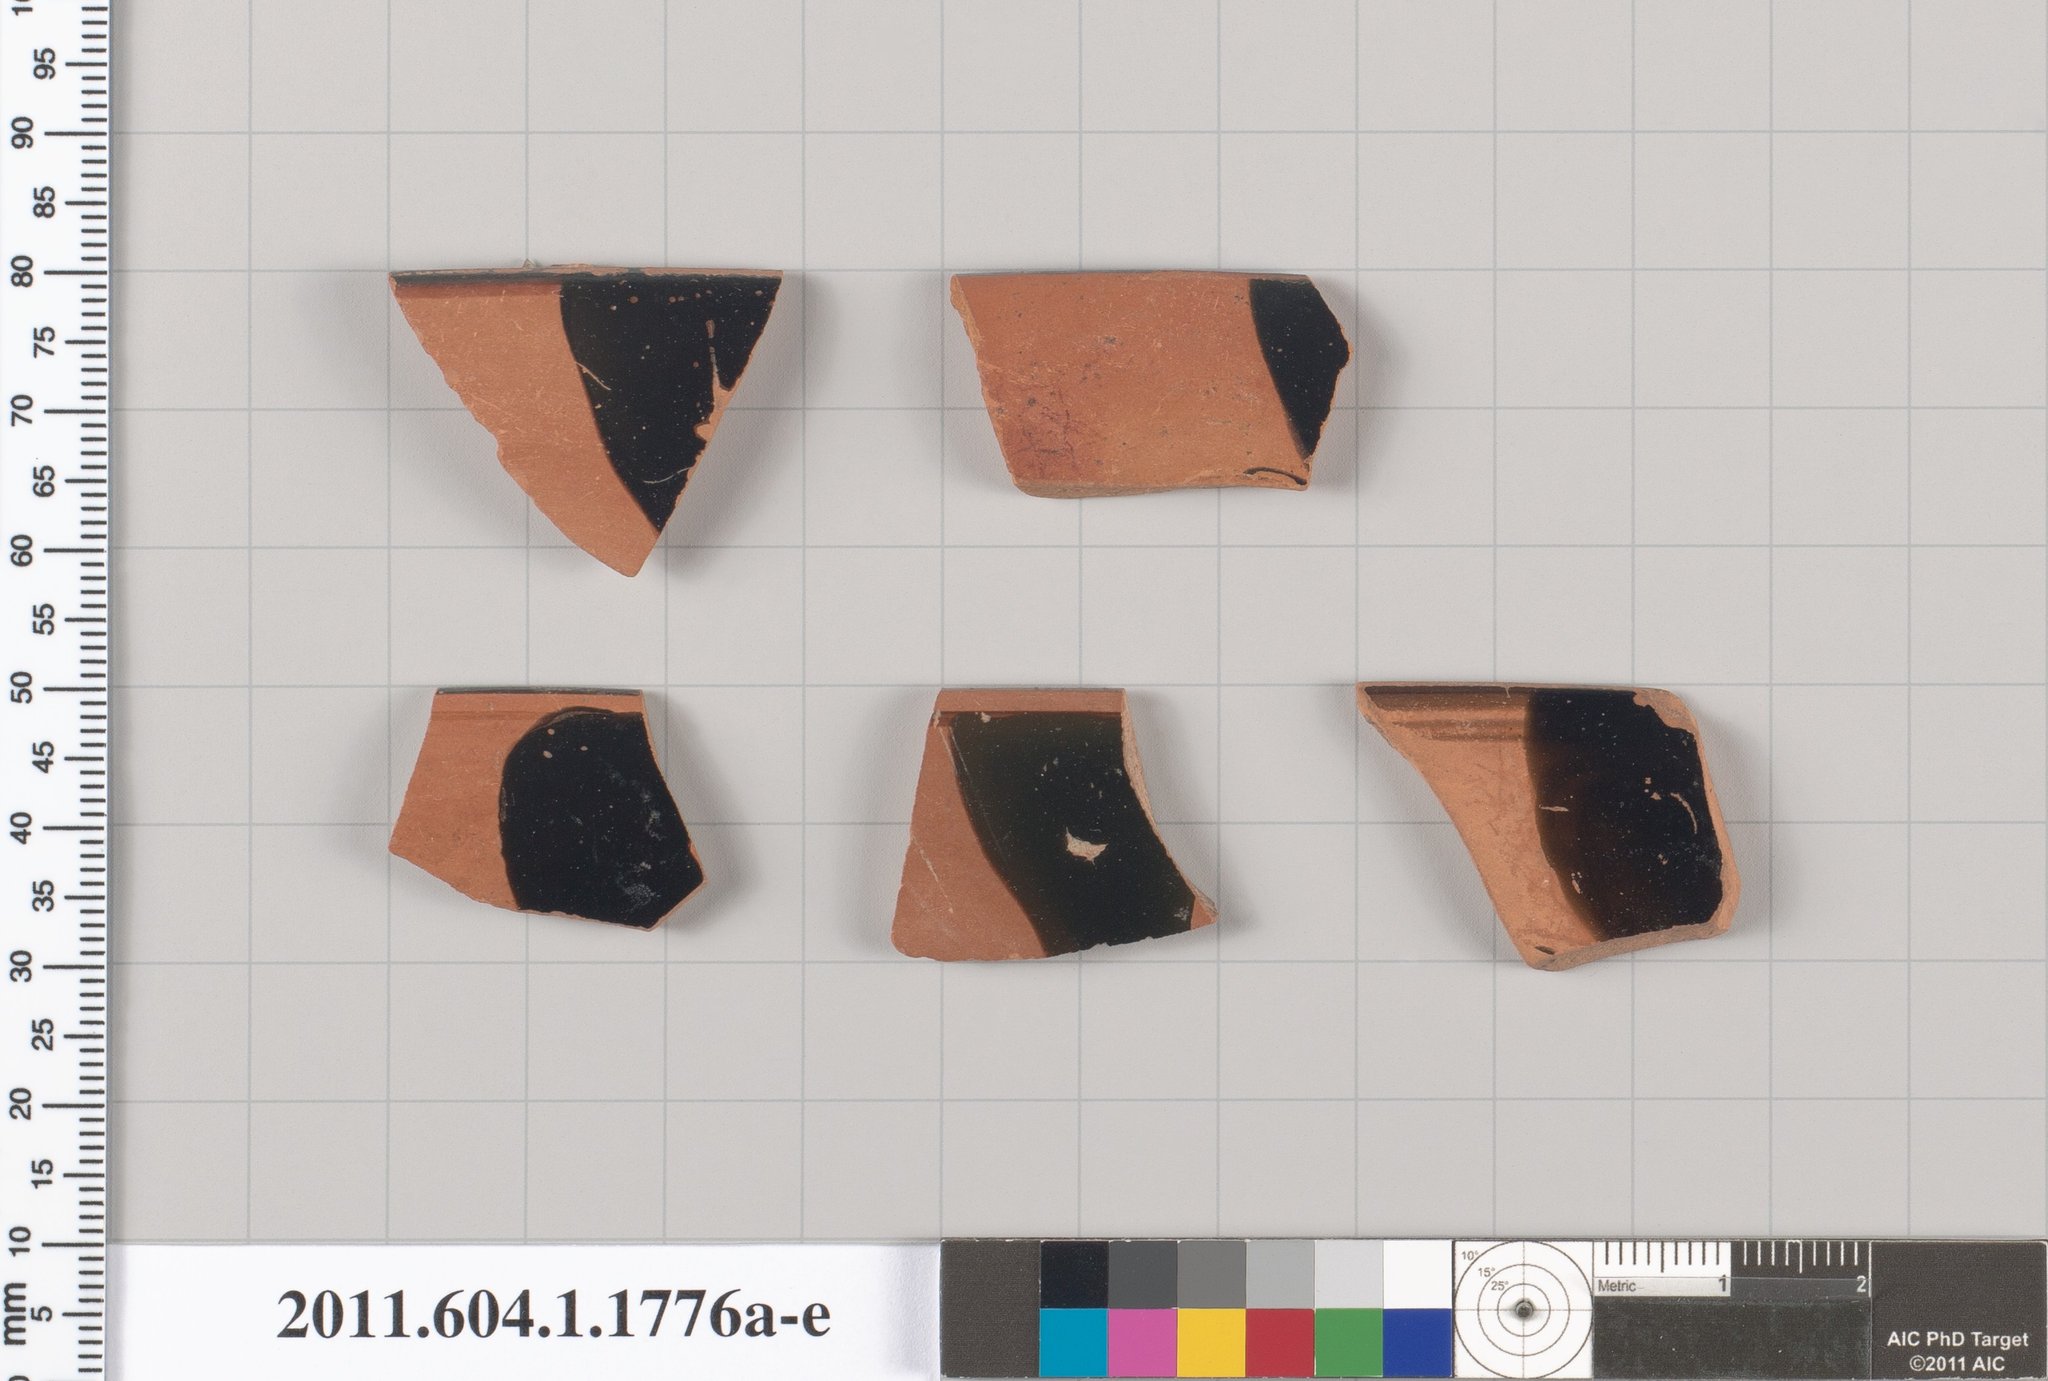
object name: kylix fragment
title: Terracotta rim fragments of kylikes(drinking cups)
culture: greek, attic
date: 500-401 BCE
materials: terracotta